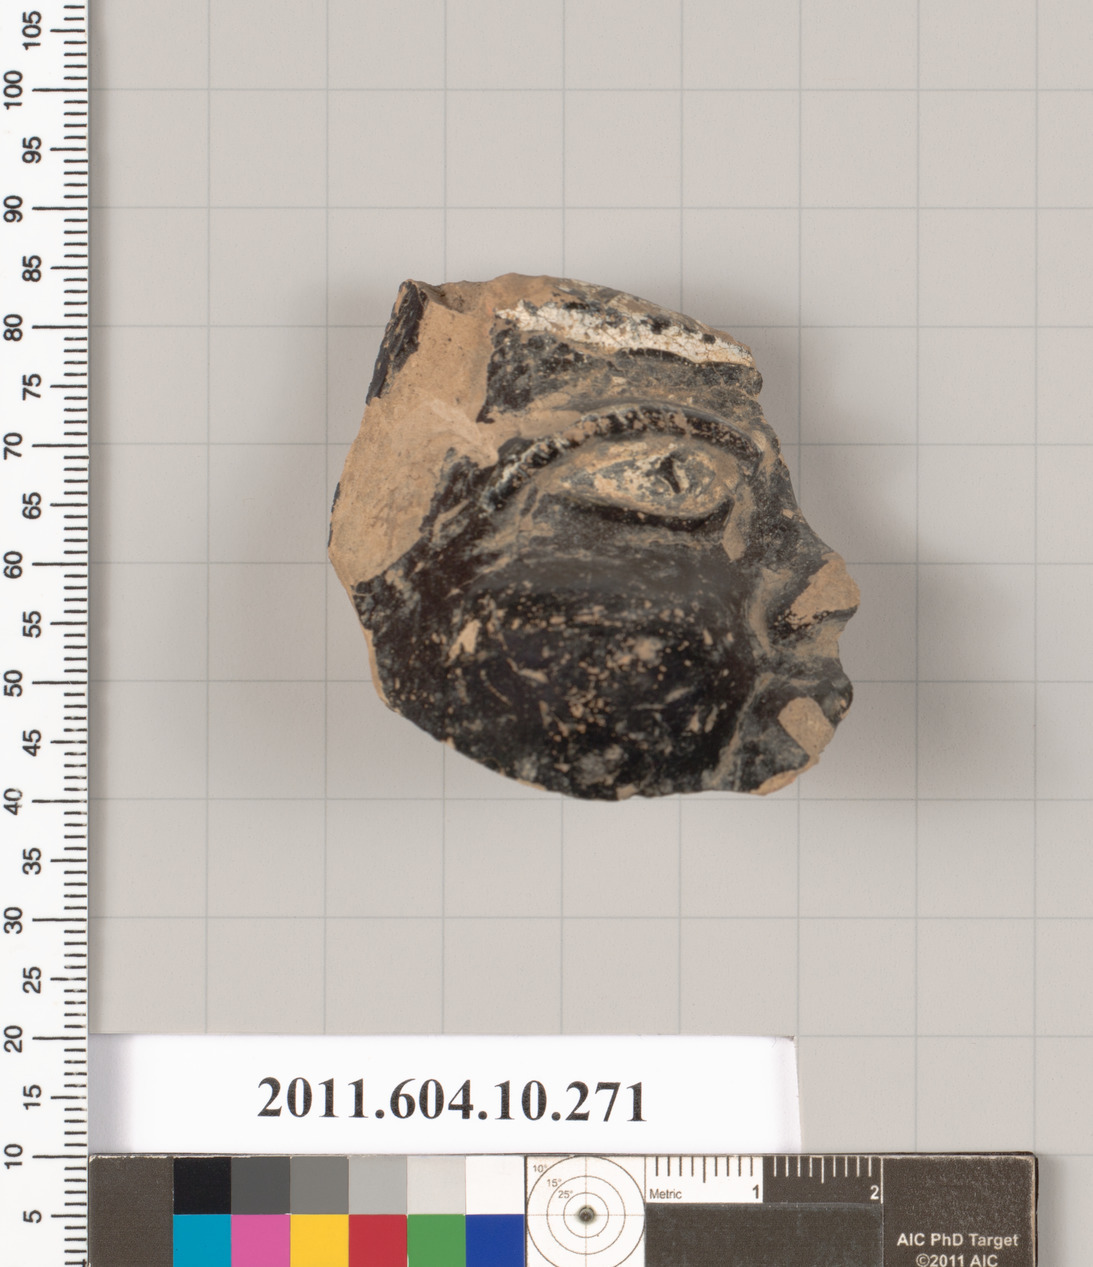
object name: plastic vase fragment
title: Terracotta fragment of a plastic vase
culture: etruscan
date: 434-368 BCE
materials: terracotta